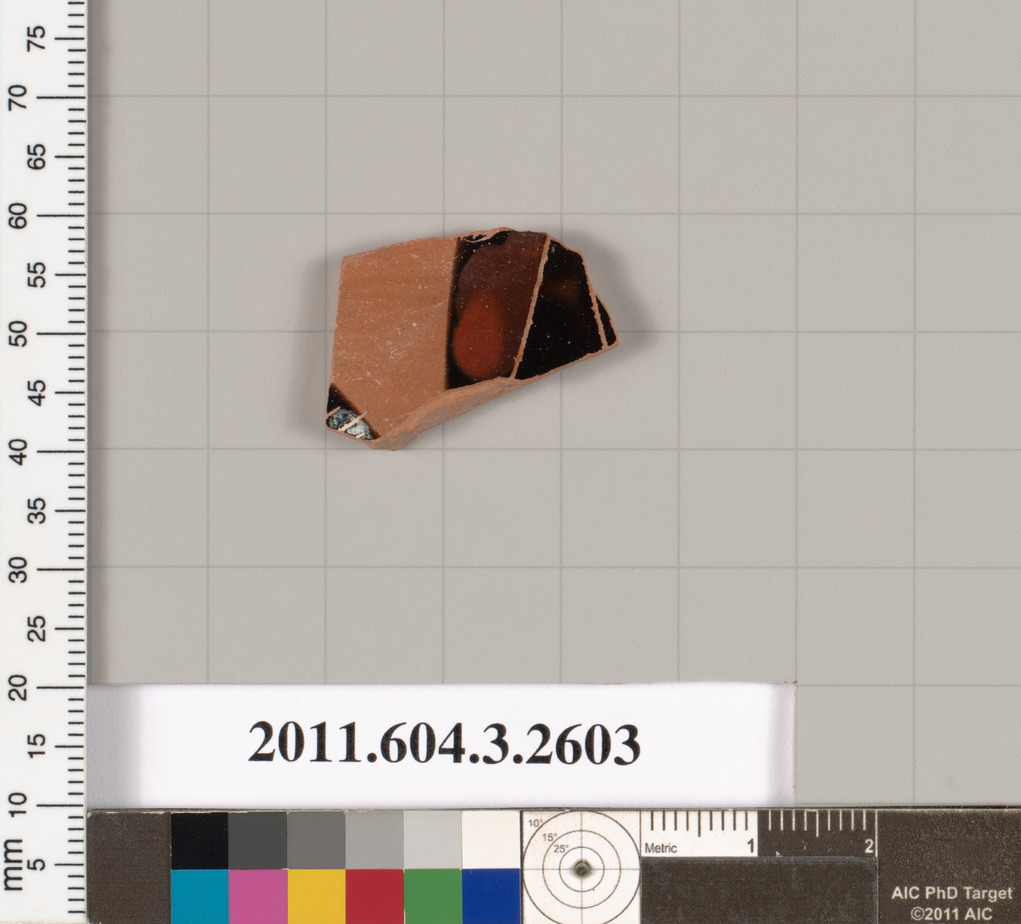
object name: kylix fragment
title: Terracotta fragment of a kylix (drinking cup)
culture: greek, attic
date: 550-526 BCE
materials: terracotta